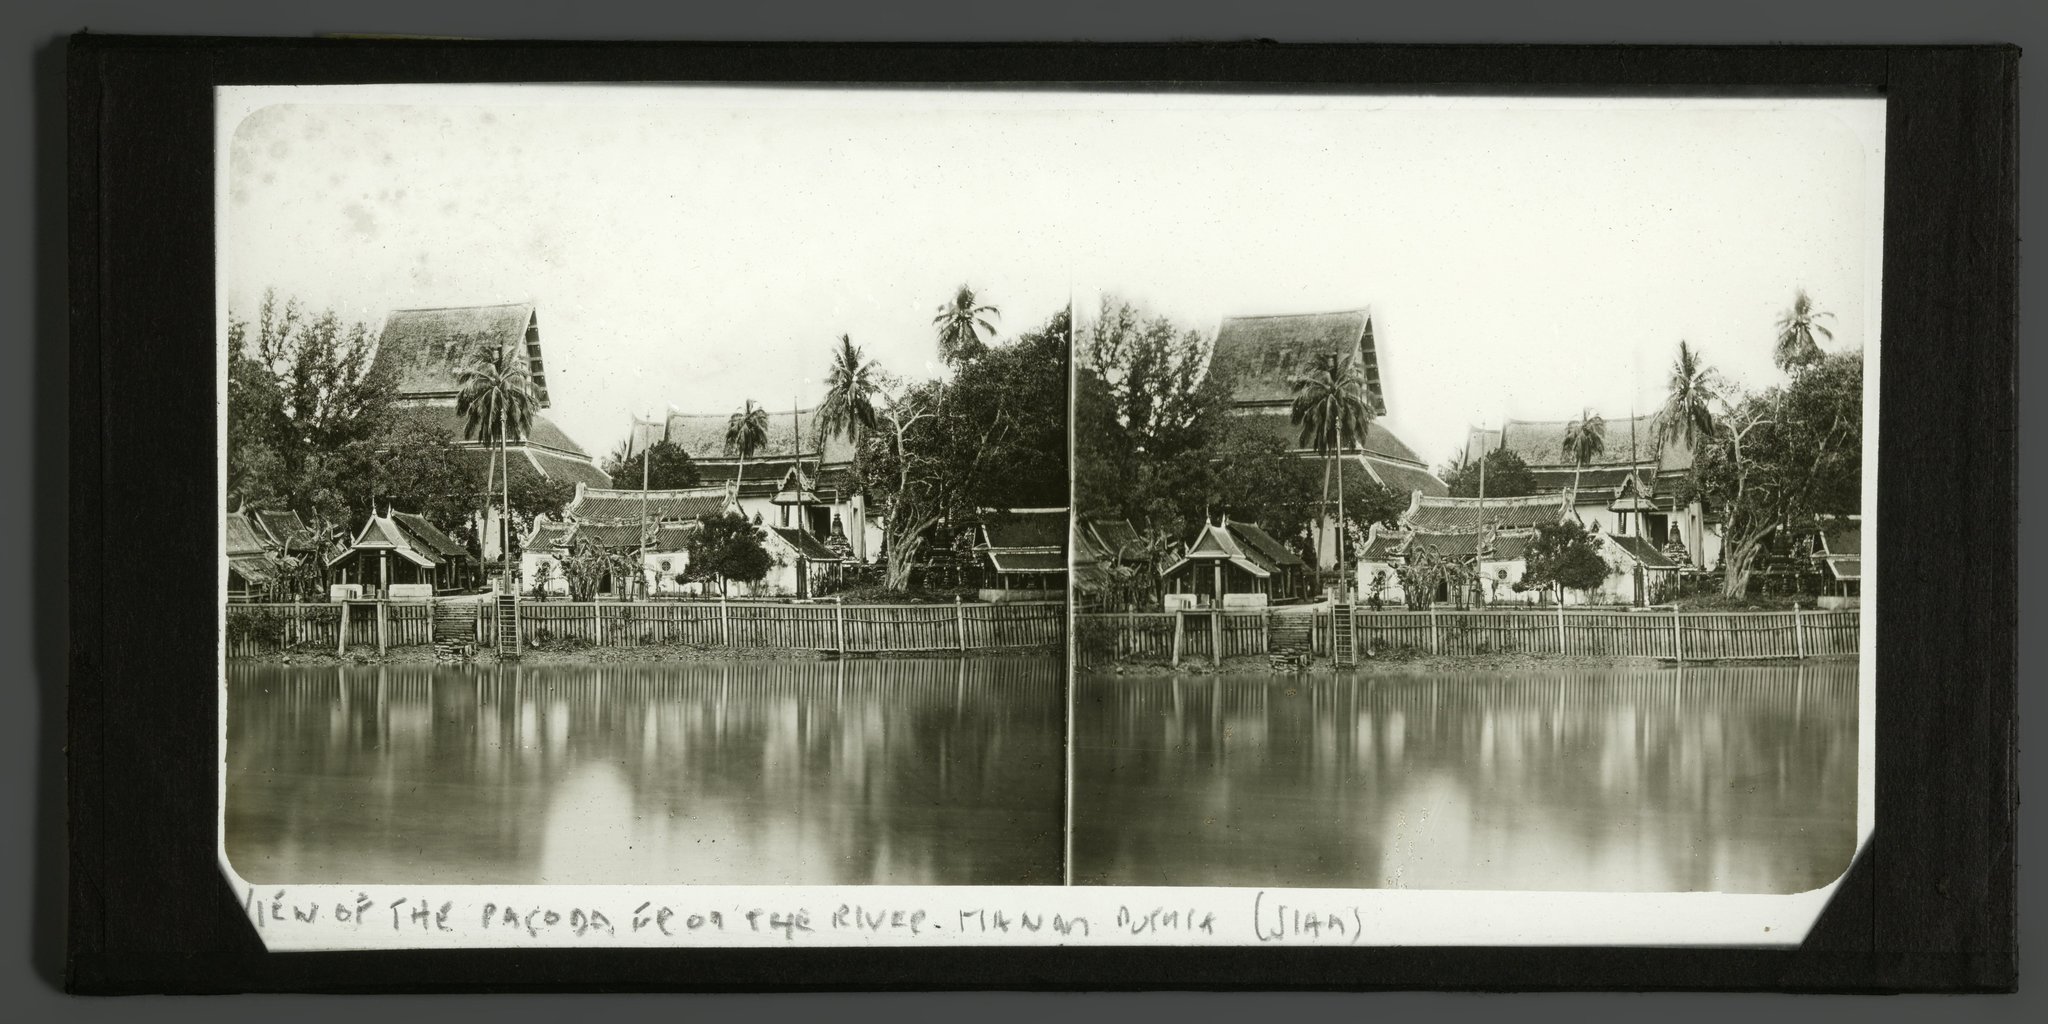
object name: stereoscopic photograph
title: Gezicht op huizen en een tempel bij een rivier in Thailand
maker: Anonymous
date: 1860-1890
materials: glass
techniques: slide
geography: thailand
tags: temple, shrine ~ hinduism, buddhism, jainism, river, thailand